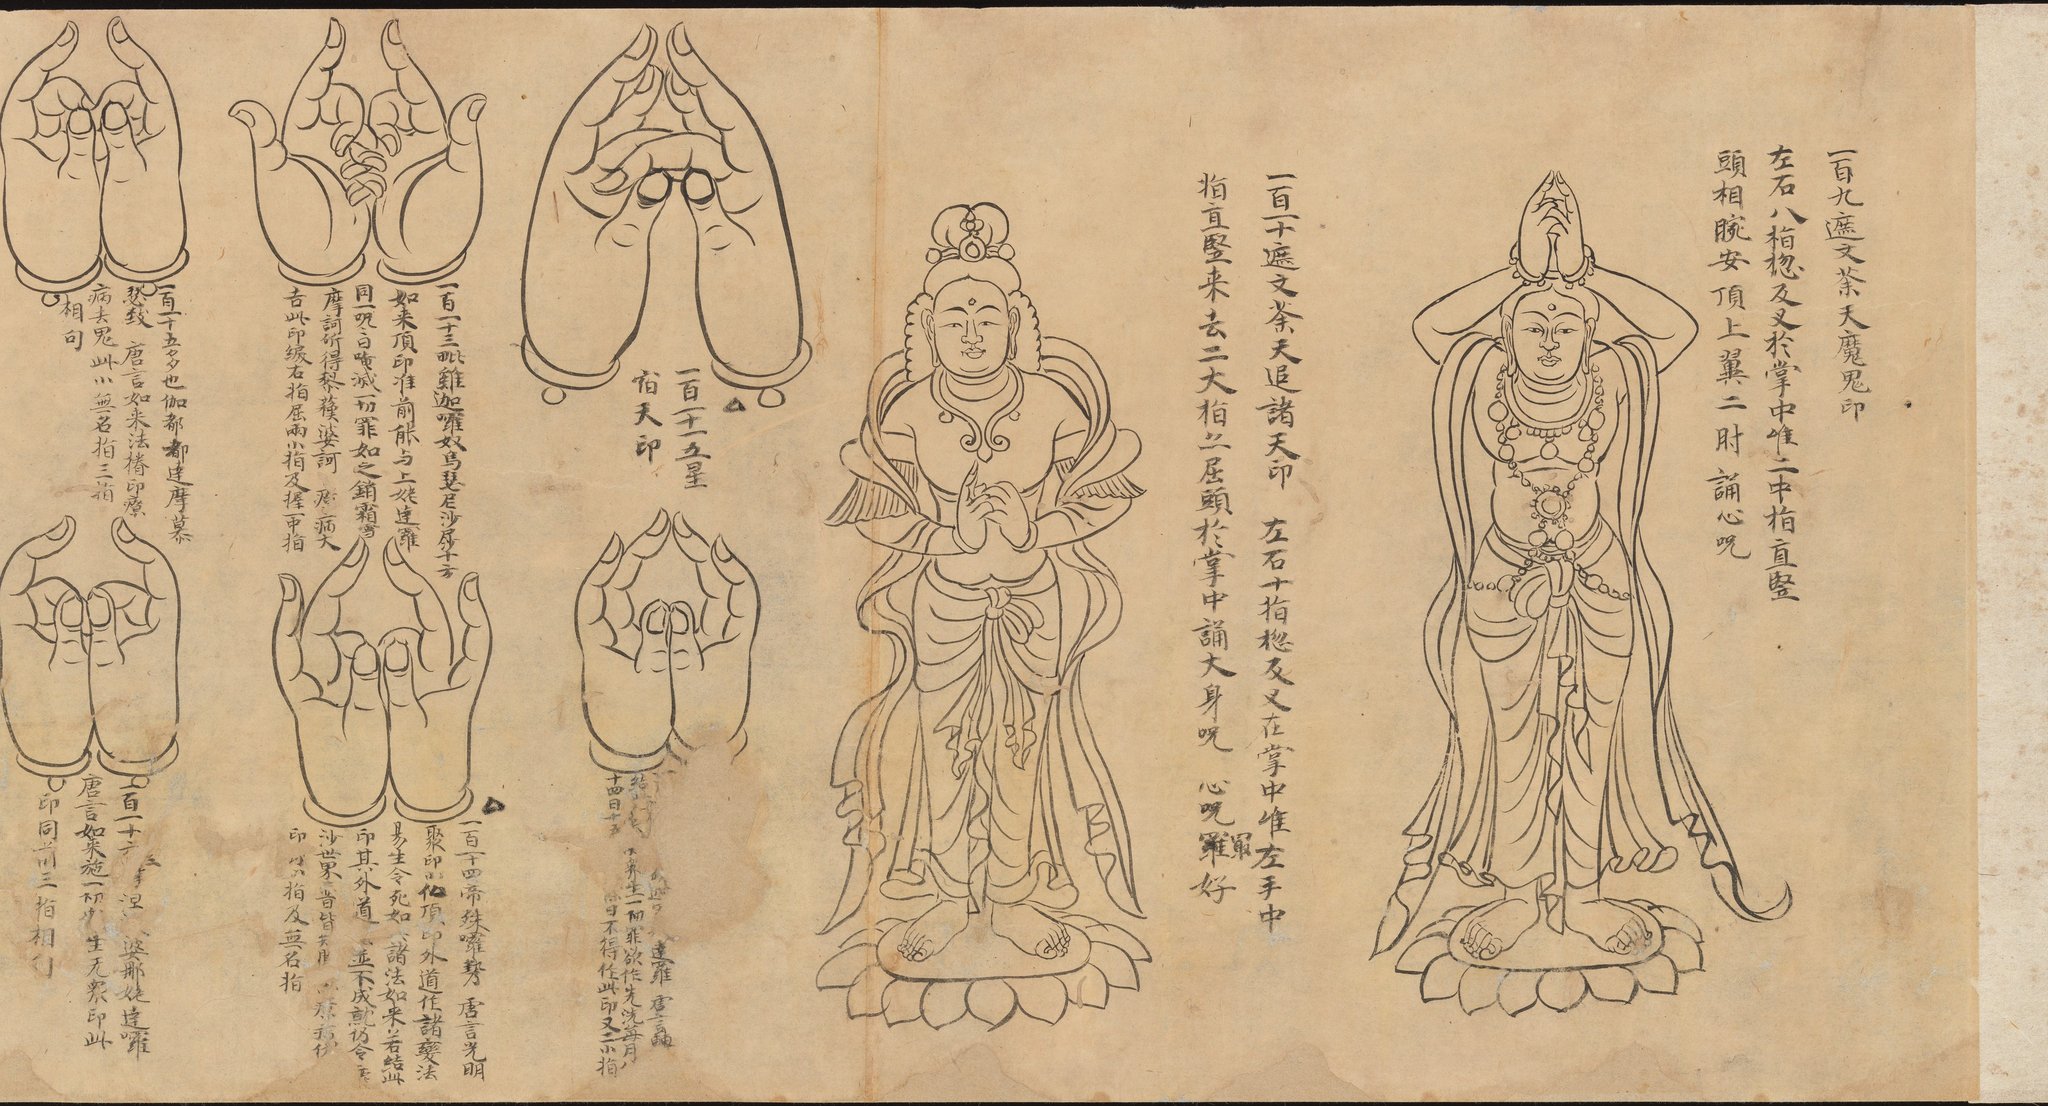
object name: handscroll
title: Scroll of Mudras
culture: japanese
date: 1001-1200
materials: ink, paper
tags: hands,buddhism